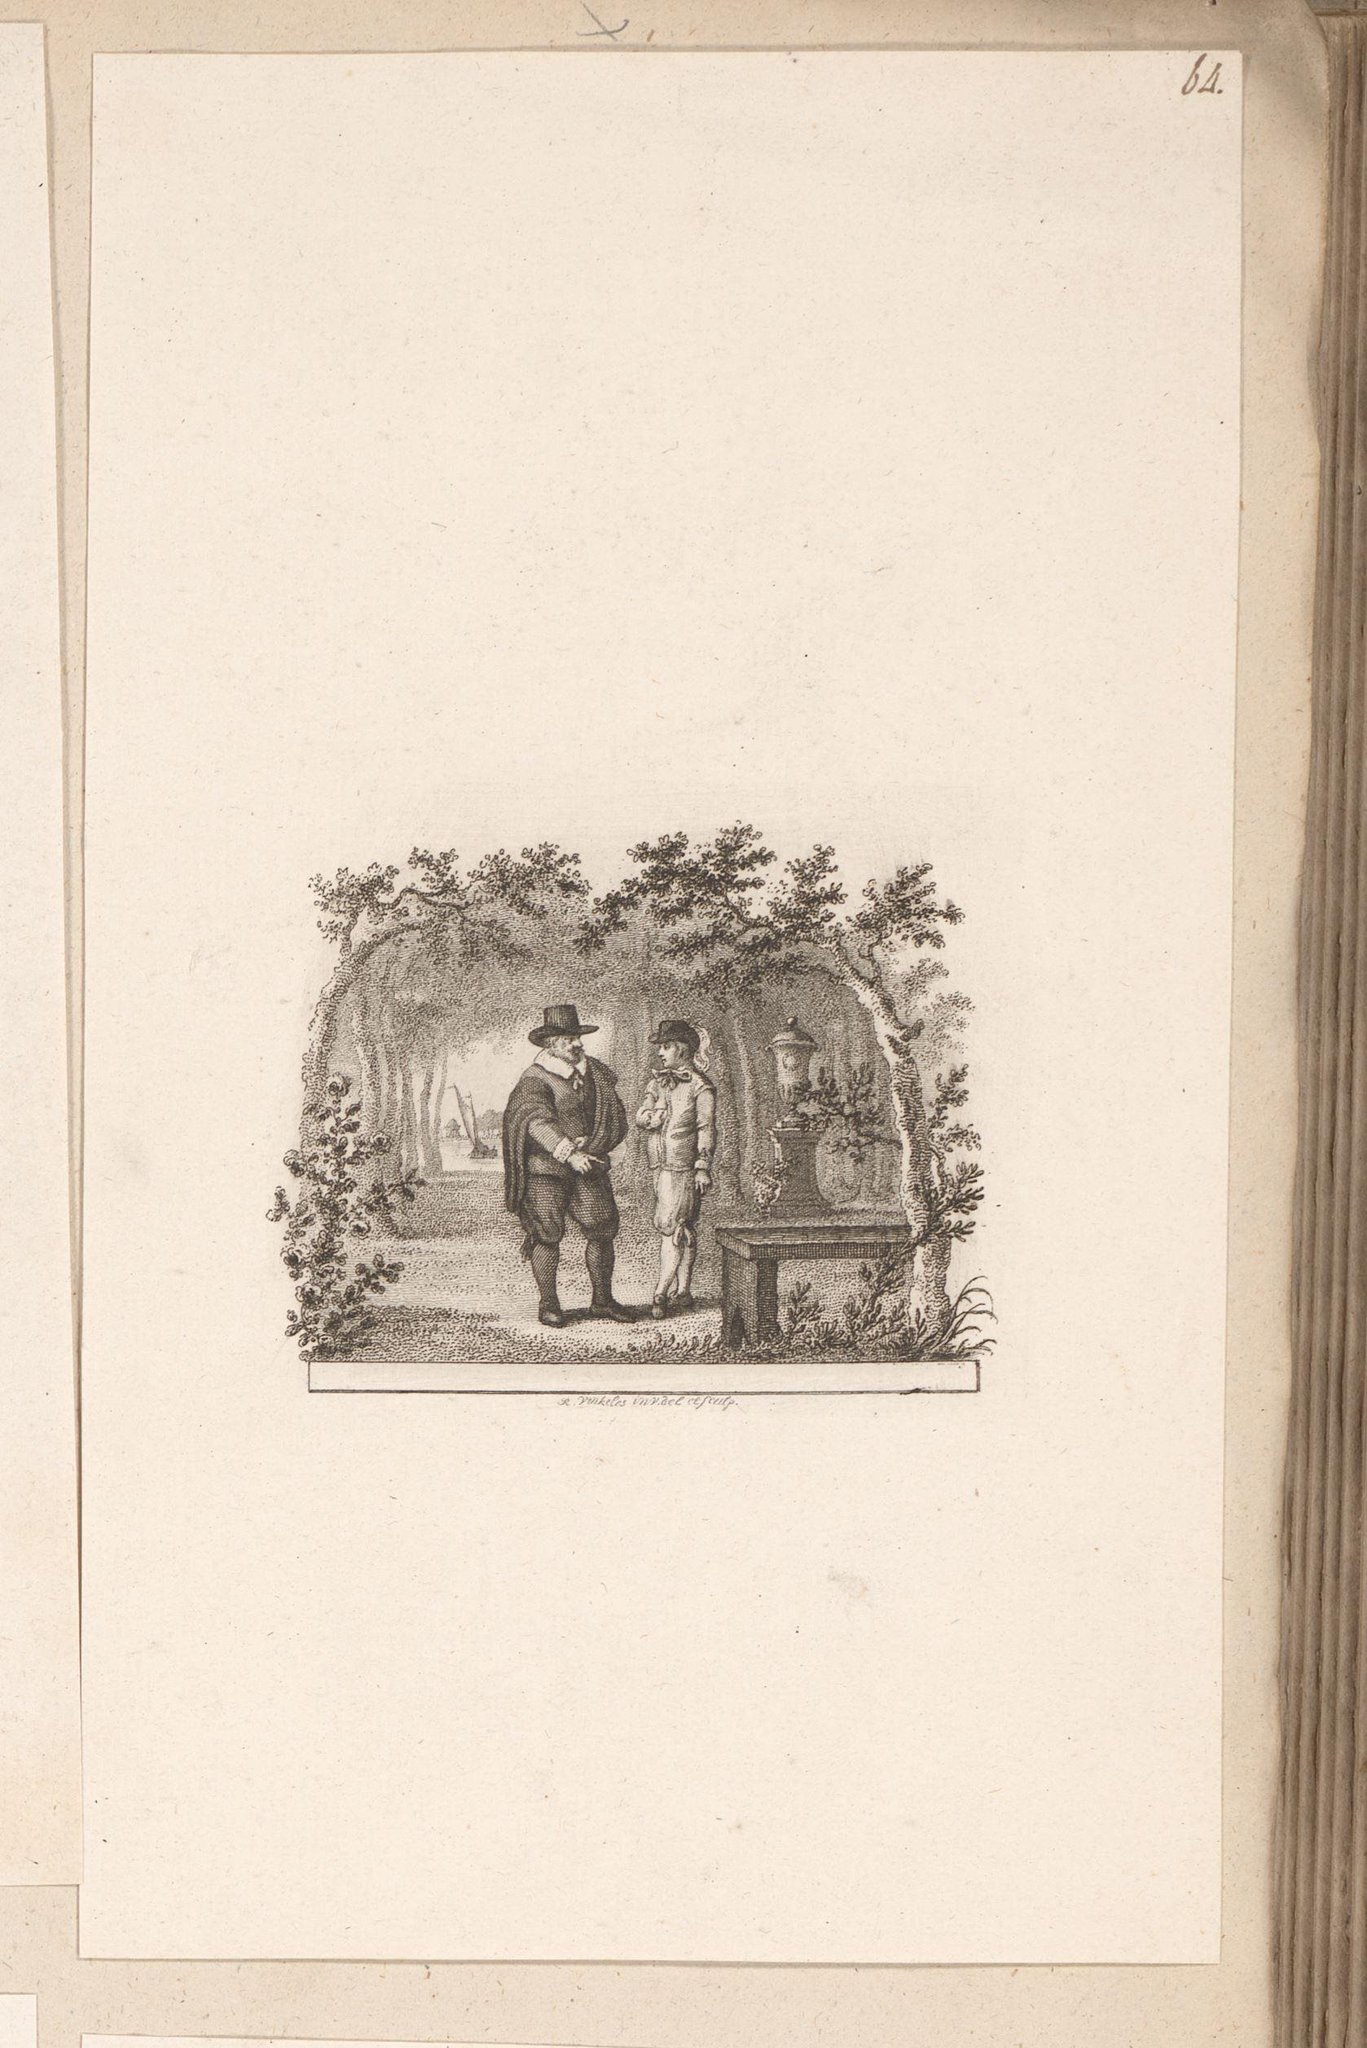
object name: titelblad, titelpagina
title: Titelpagina voor: Adriaan Pietersz. Loosjes, Het leven van Robbert Hellemans, 1815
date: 1815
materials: paper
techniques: engraving, etching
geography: amsterdam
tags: ships (in general), forest, wood, meeting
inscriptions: inscription: ‘64’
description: Een man en jongen staan op een open plek in een bos. Op de achtergrond een doorkijkje met een schip. Rechts een tuinvaas. De prent maakt deel uit van een album.